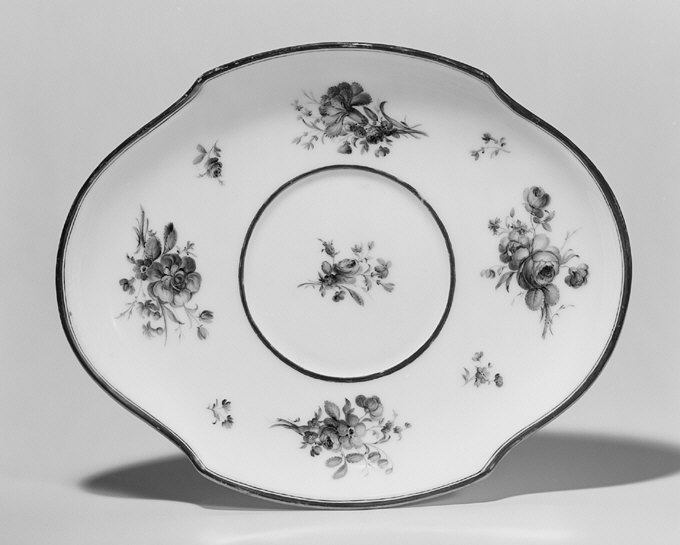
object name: tray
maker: dihl et guérhard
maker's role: factory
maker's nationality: french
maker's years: 1781-1824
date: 1790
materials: hard paste porcelain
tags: flowers